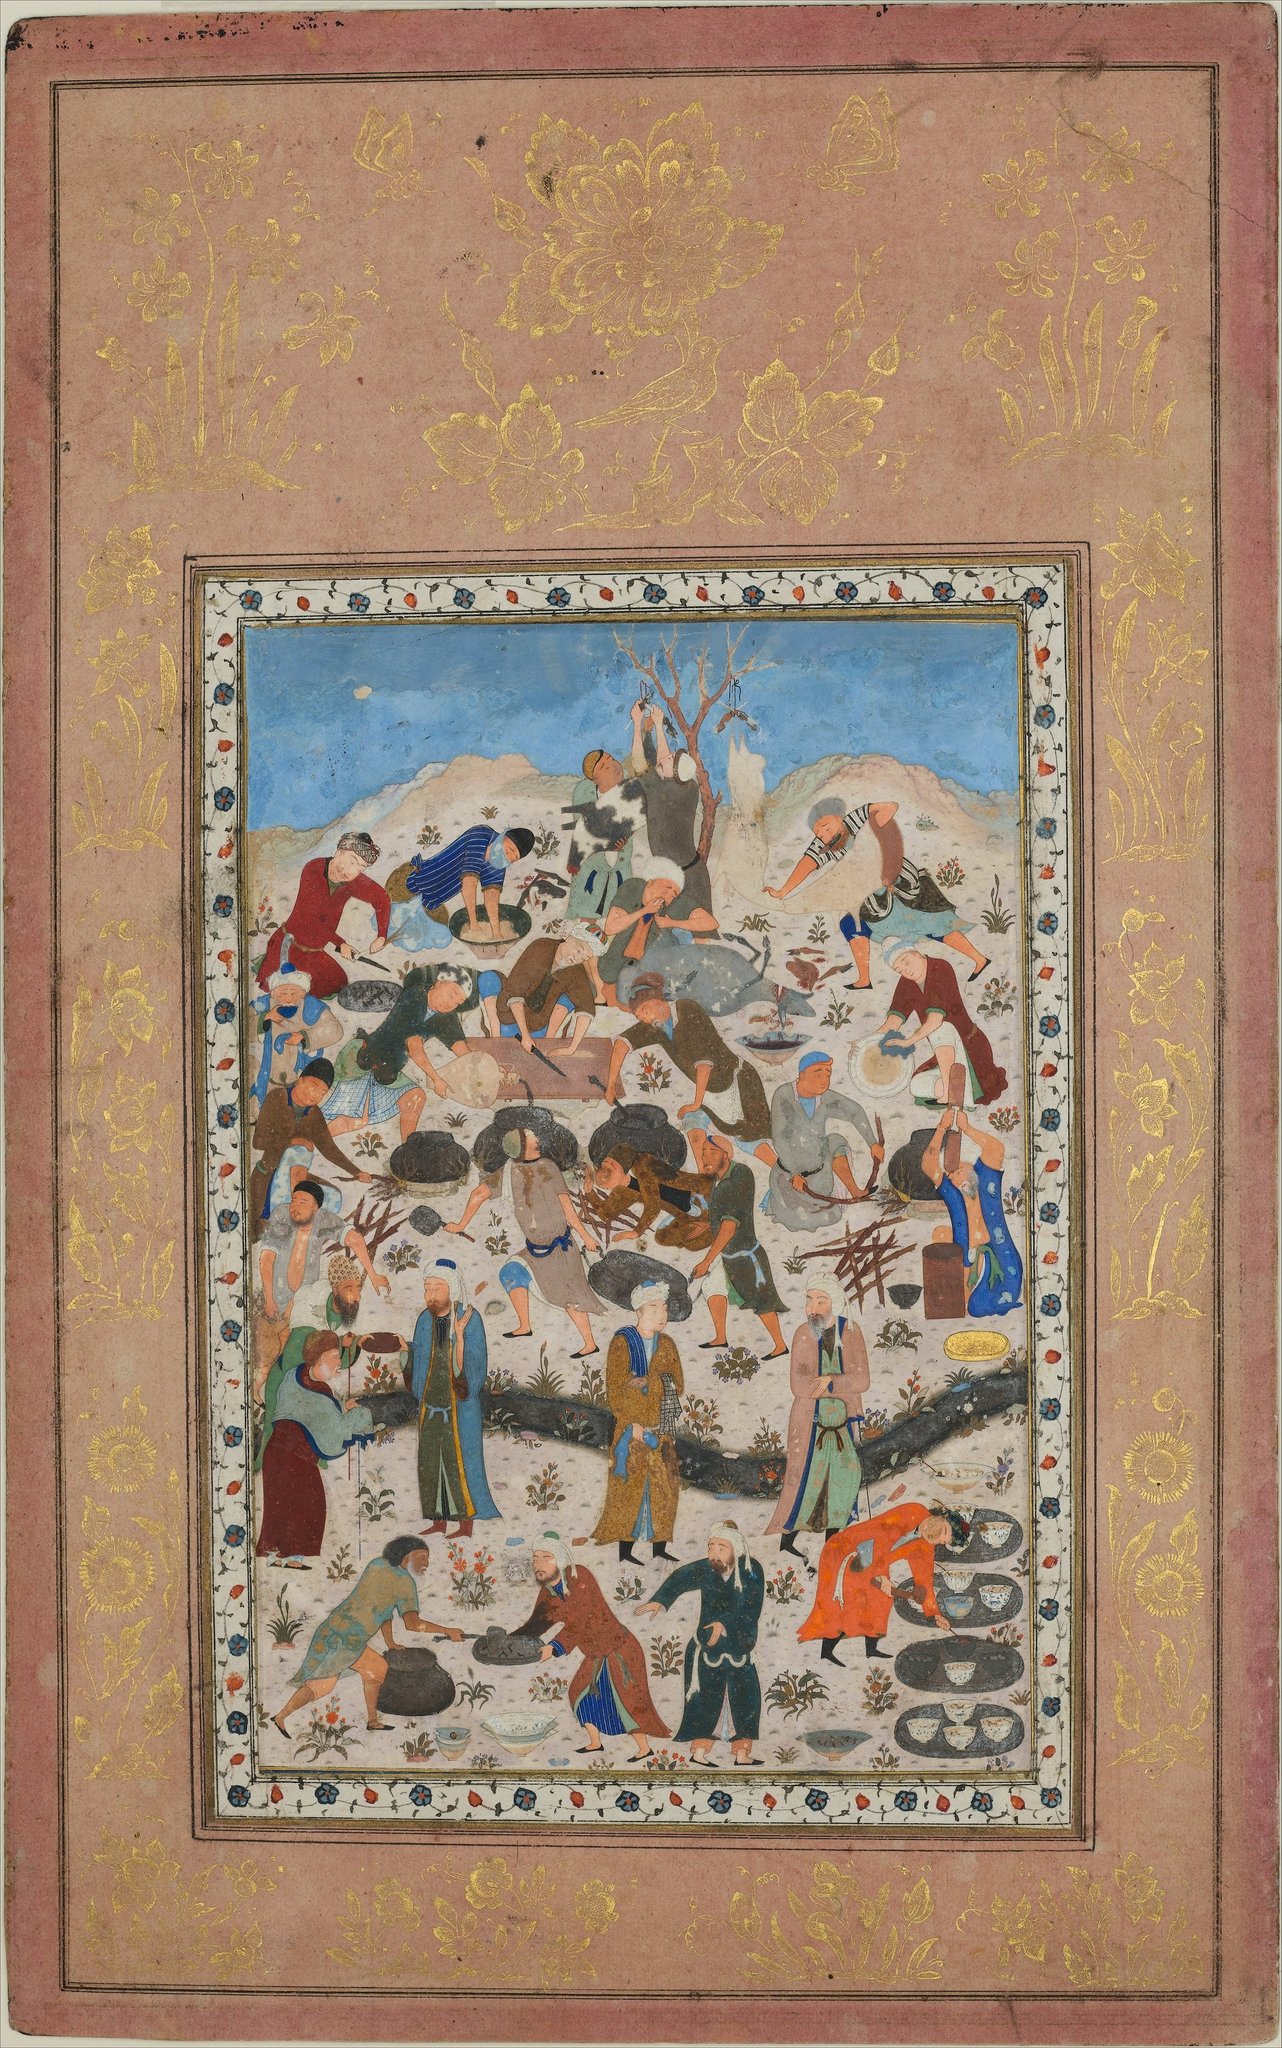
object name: folio from an illustrated manuscript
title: "Preparation for a Feast", Folio from a Divan of Jami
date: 1467-1500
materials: gold, ink, paper, watercolor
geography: afghanistan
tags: men,working